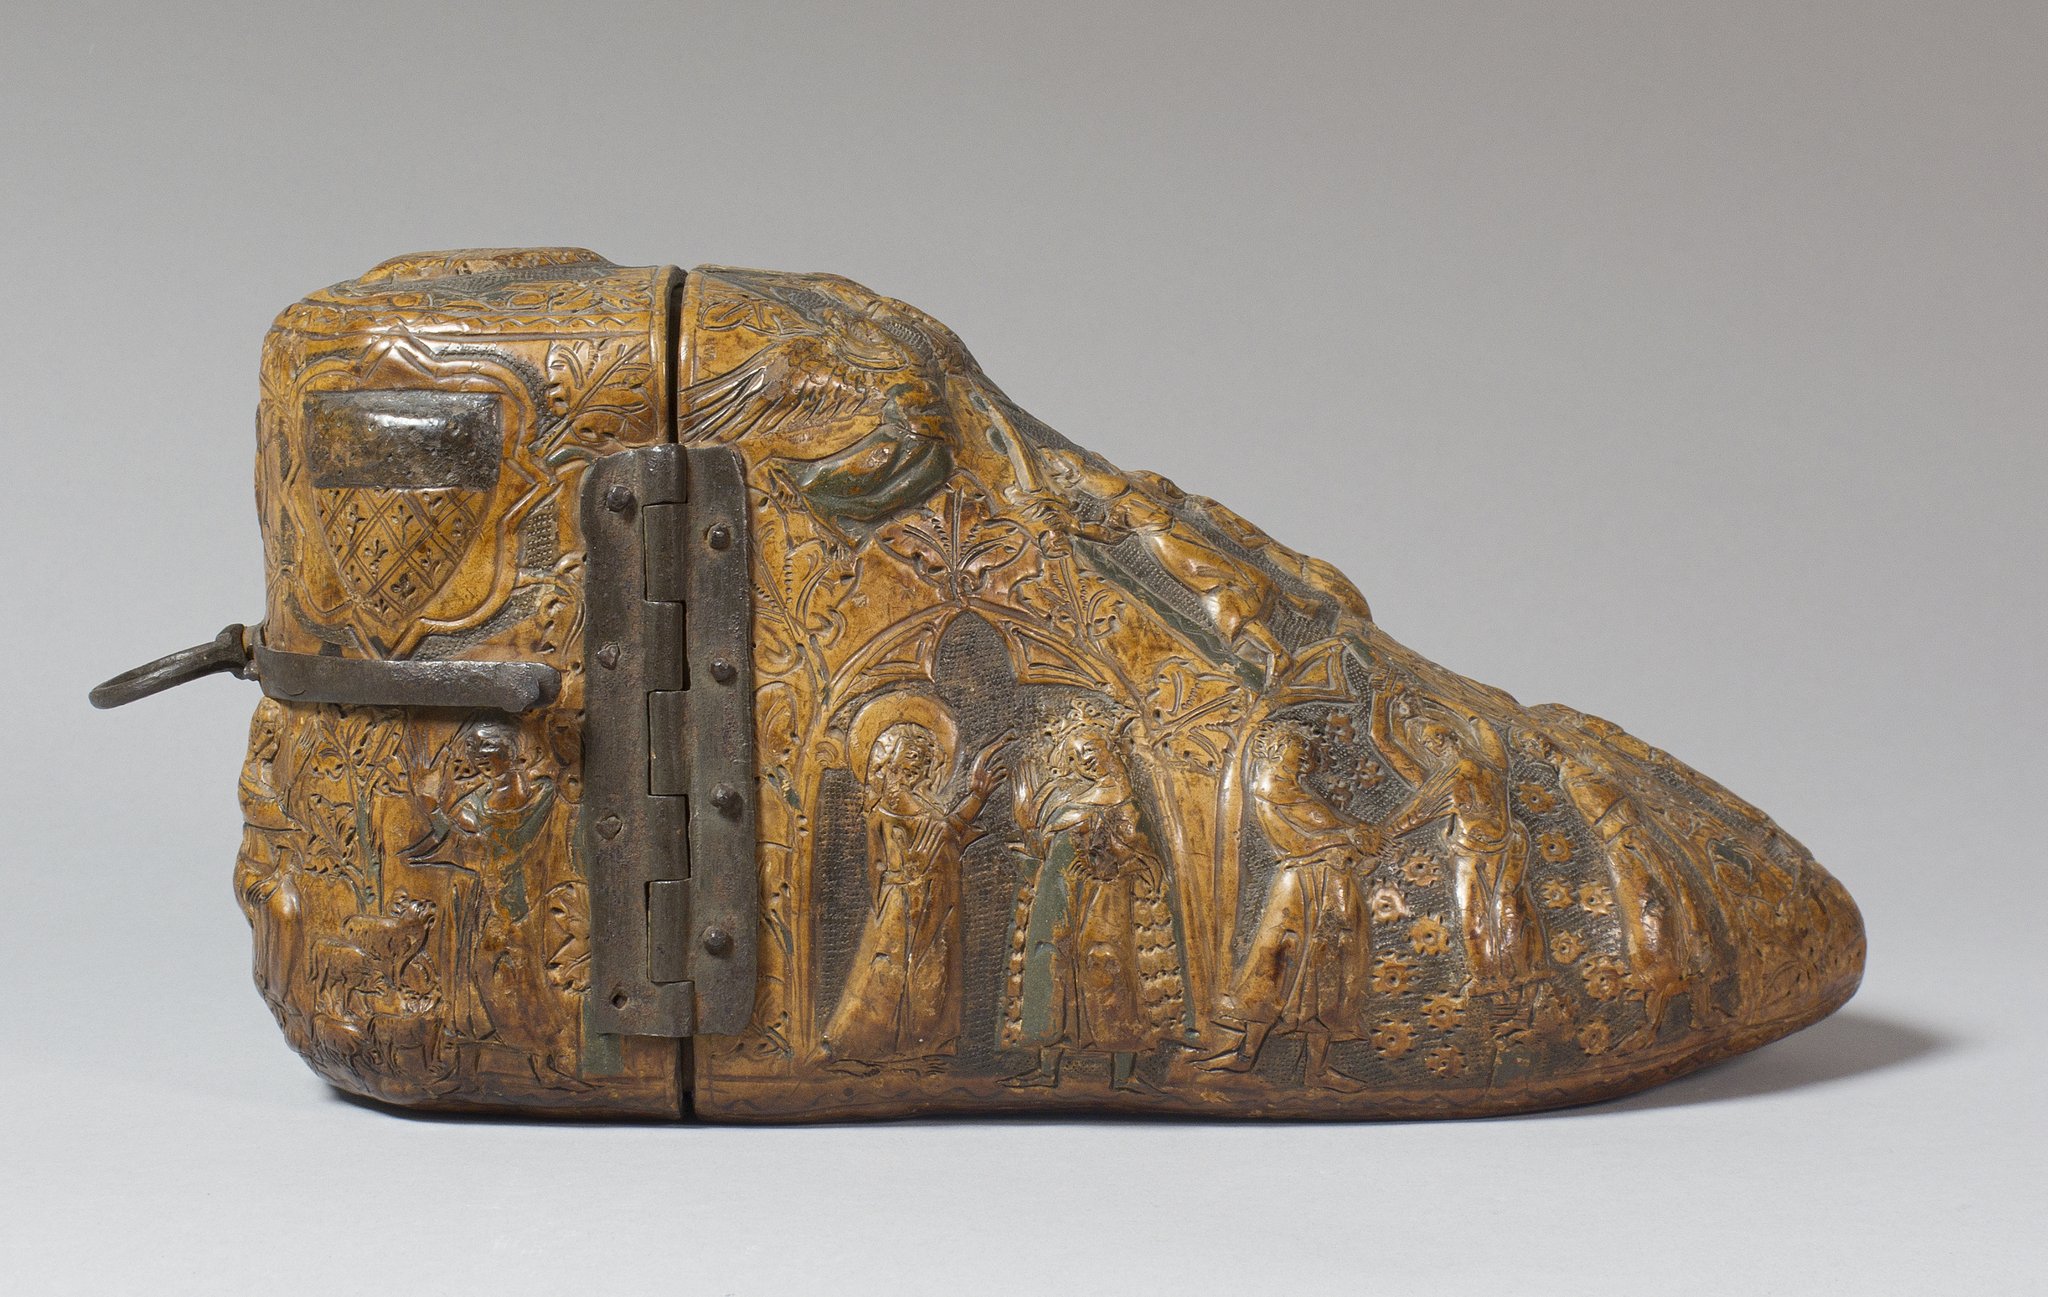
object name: reliquary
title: Shoe Reliquary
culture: french or swiss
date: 1350-1400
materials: iron, leather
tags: shoes,women,dragons,saints